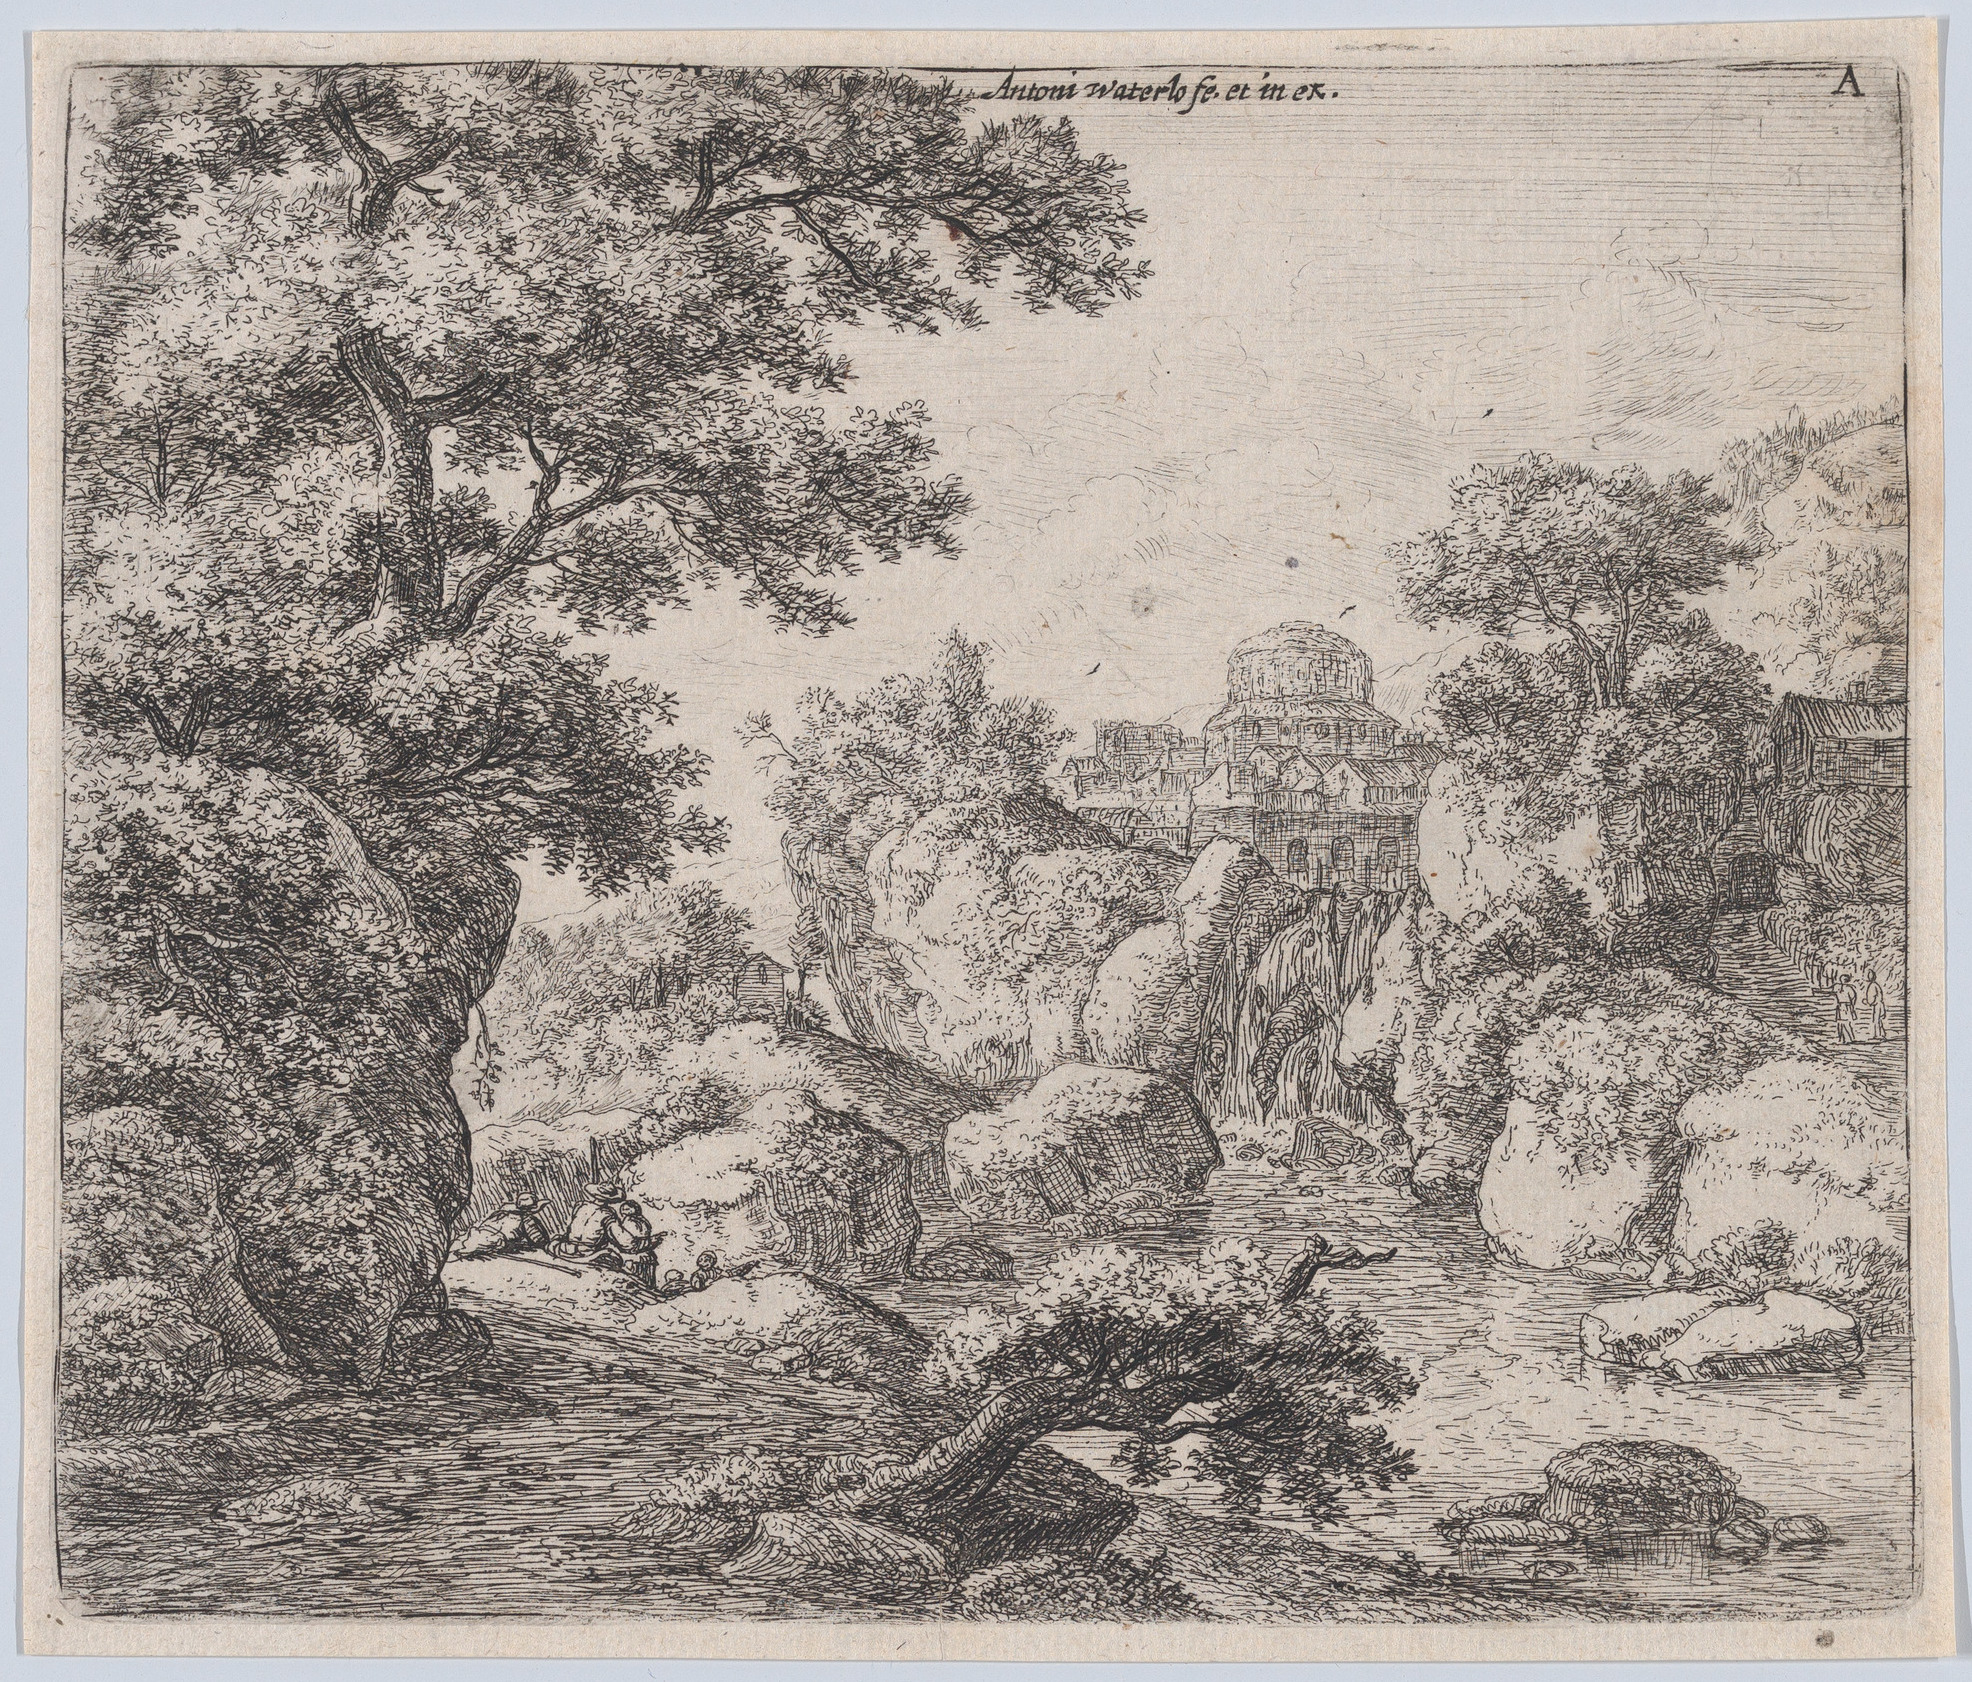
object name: print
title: The Dome and the Waterfall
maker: anthonie waterloo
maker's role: artist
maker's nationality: dutch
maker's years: 1609-1690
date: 1601-1700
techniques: etching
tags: architecture